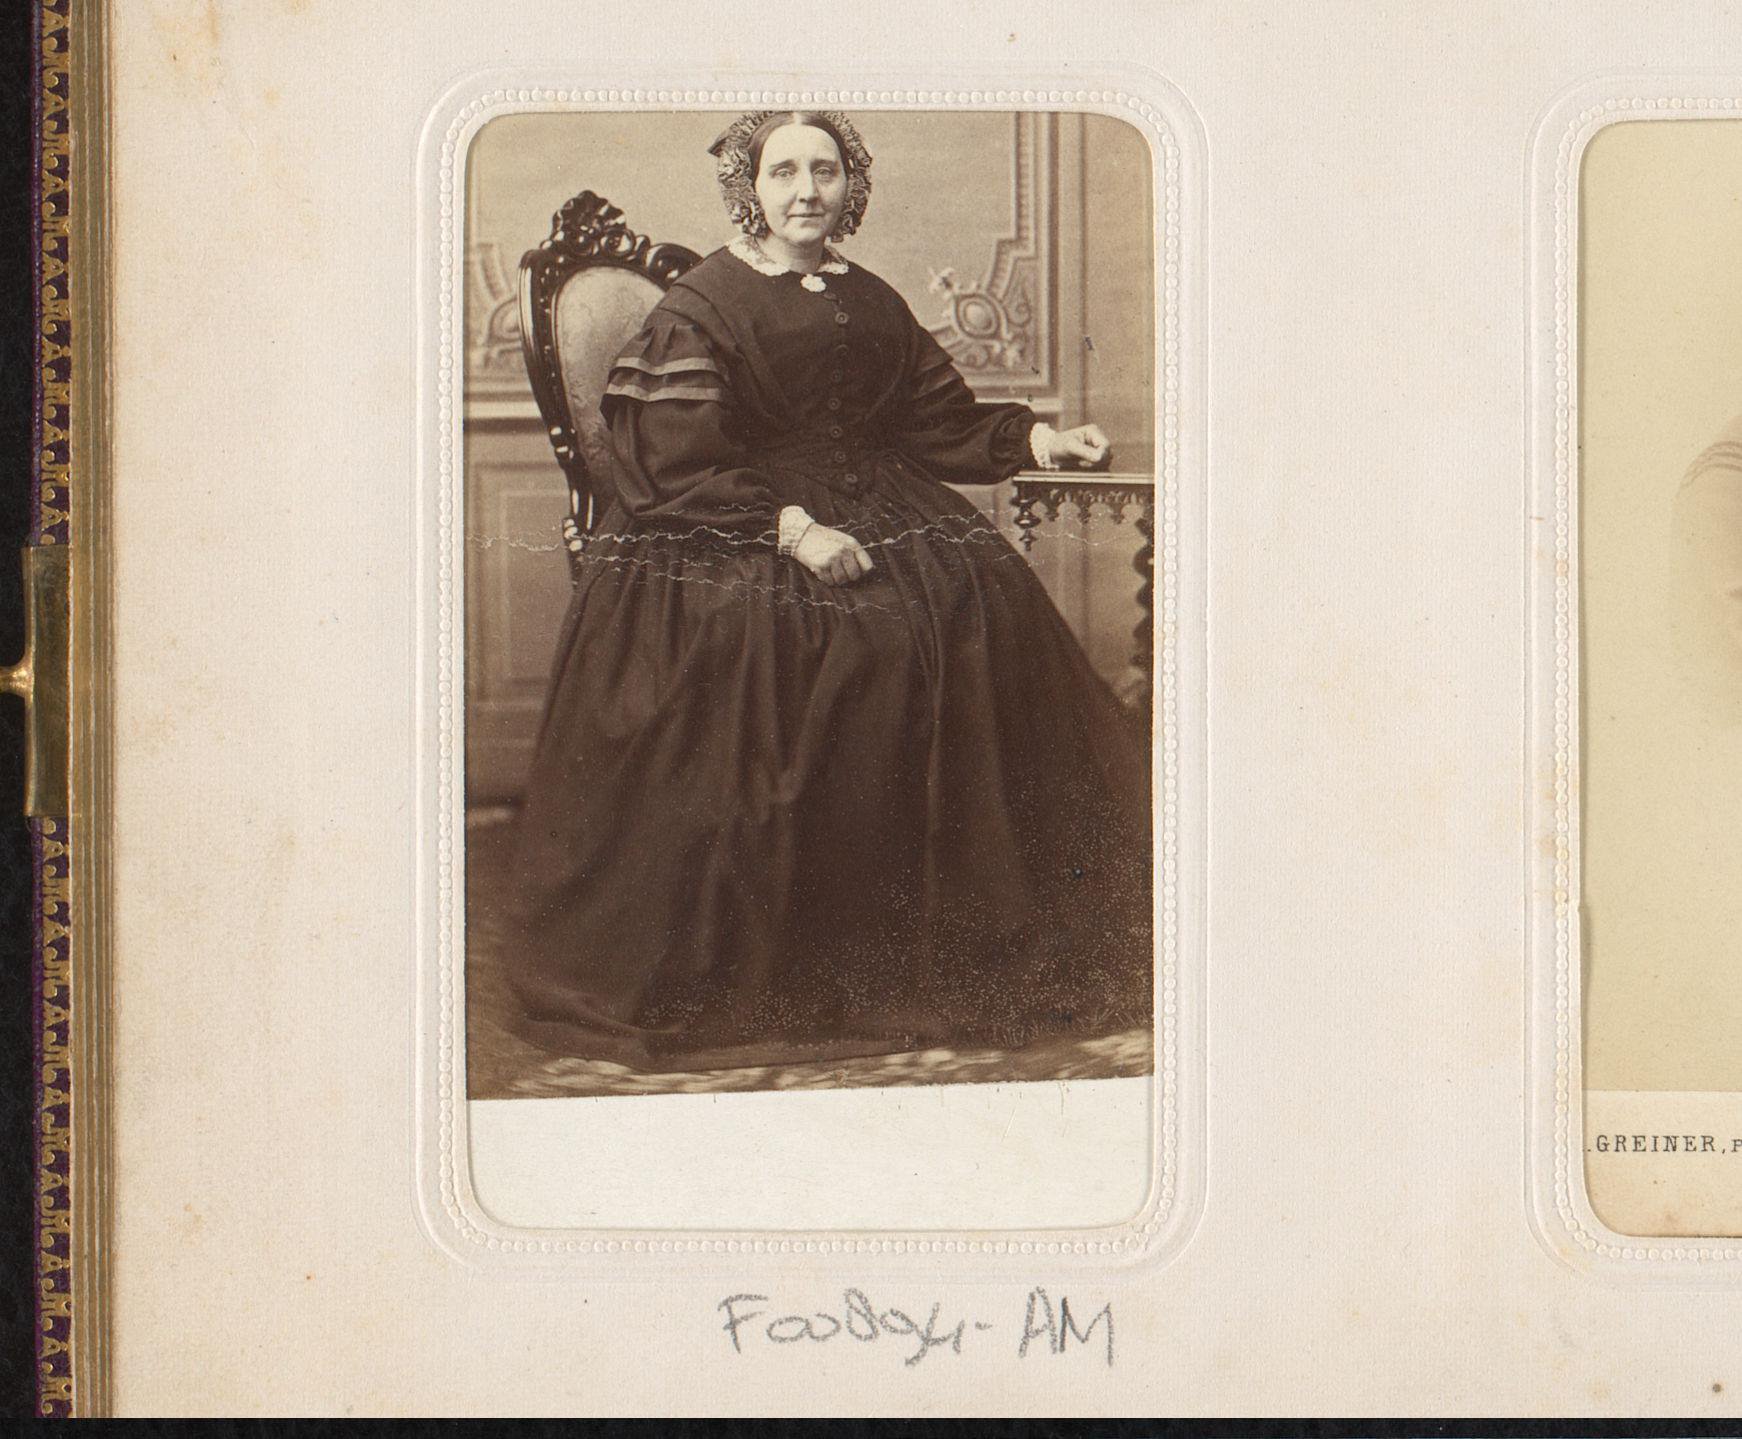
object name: carte de visite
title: Portret van een zittende vrouw met een hoofddeksel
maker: franz wilhelm deutmann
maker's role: fotograaf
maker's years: 1809-1895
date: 1899-1904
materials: cardboard, photographic support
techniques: albumen print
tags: sitting figure - aa - female human figure, head-gear, historical persons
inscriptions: inscription: ‘F. W. Deutmann/ Photographie/ Amsterdam’